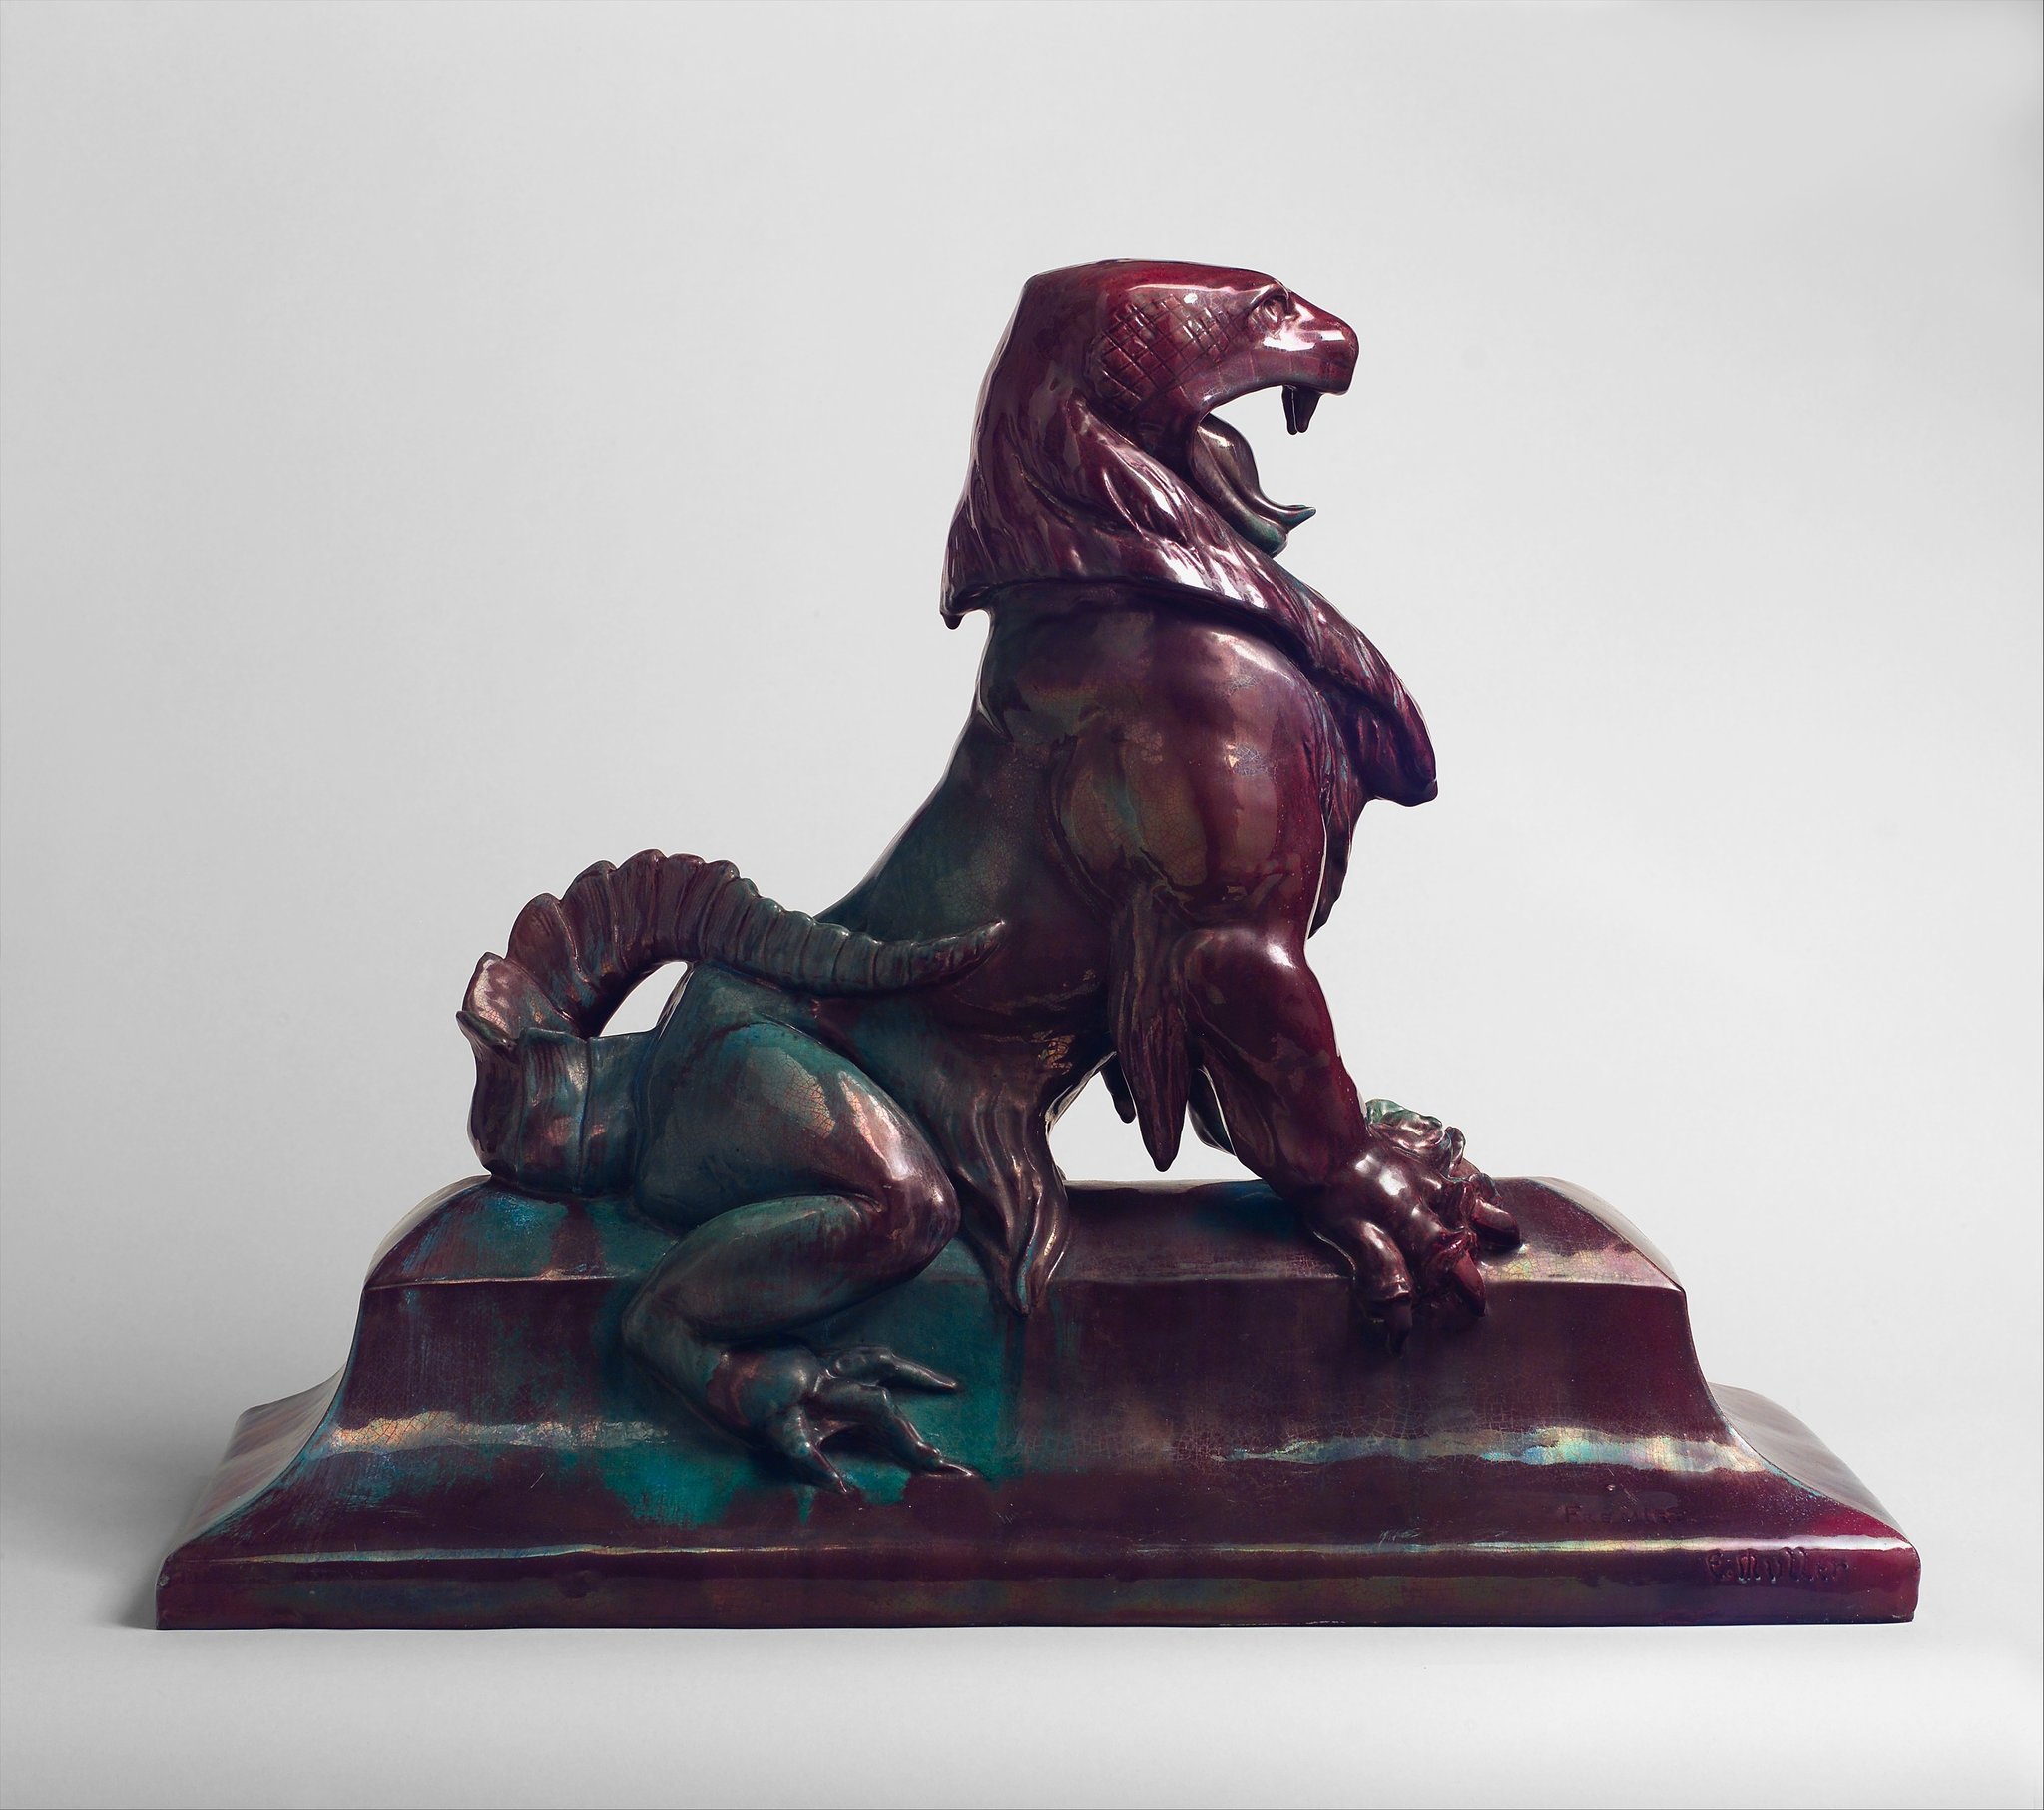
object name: statuette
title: Lizard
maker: emmanuel frémiet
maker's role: modeler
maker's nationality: french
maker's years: 1824-1910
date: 1887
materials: stoneware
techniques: glazing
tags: mythical creatures